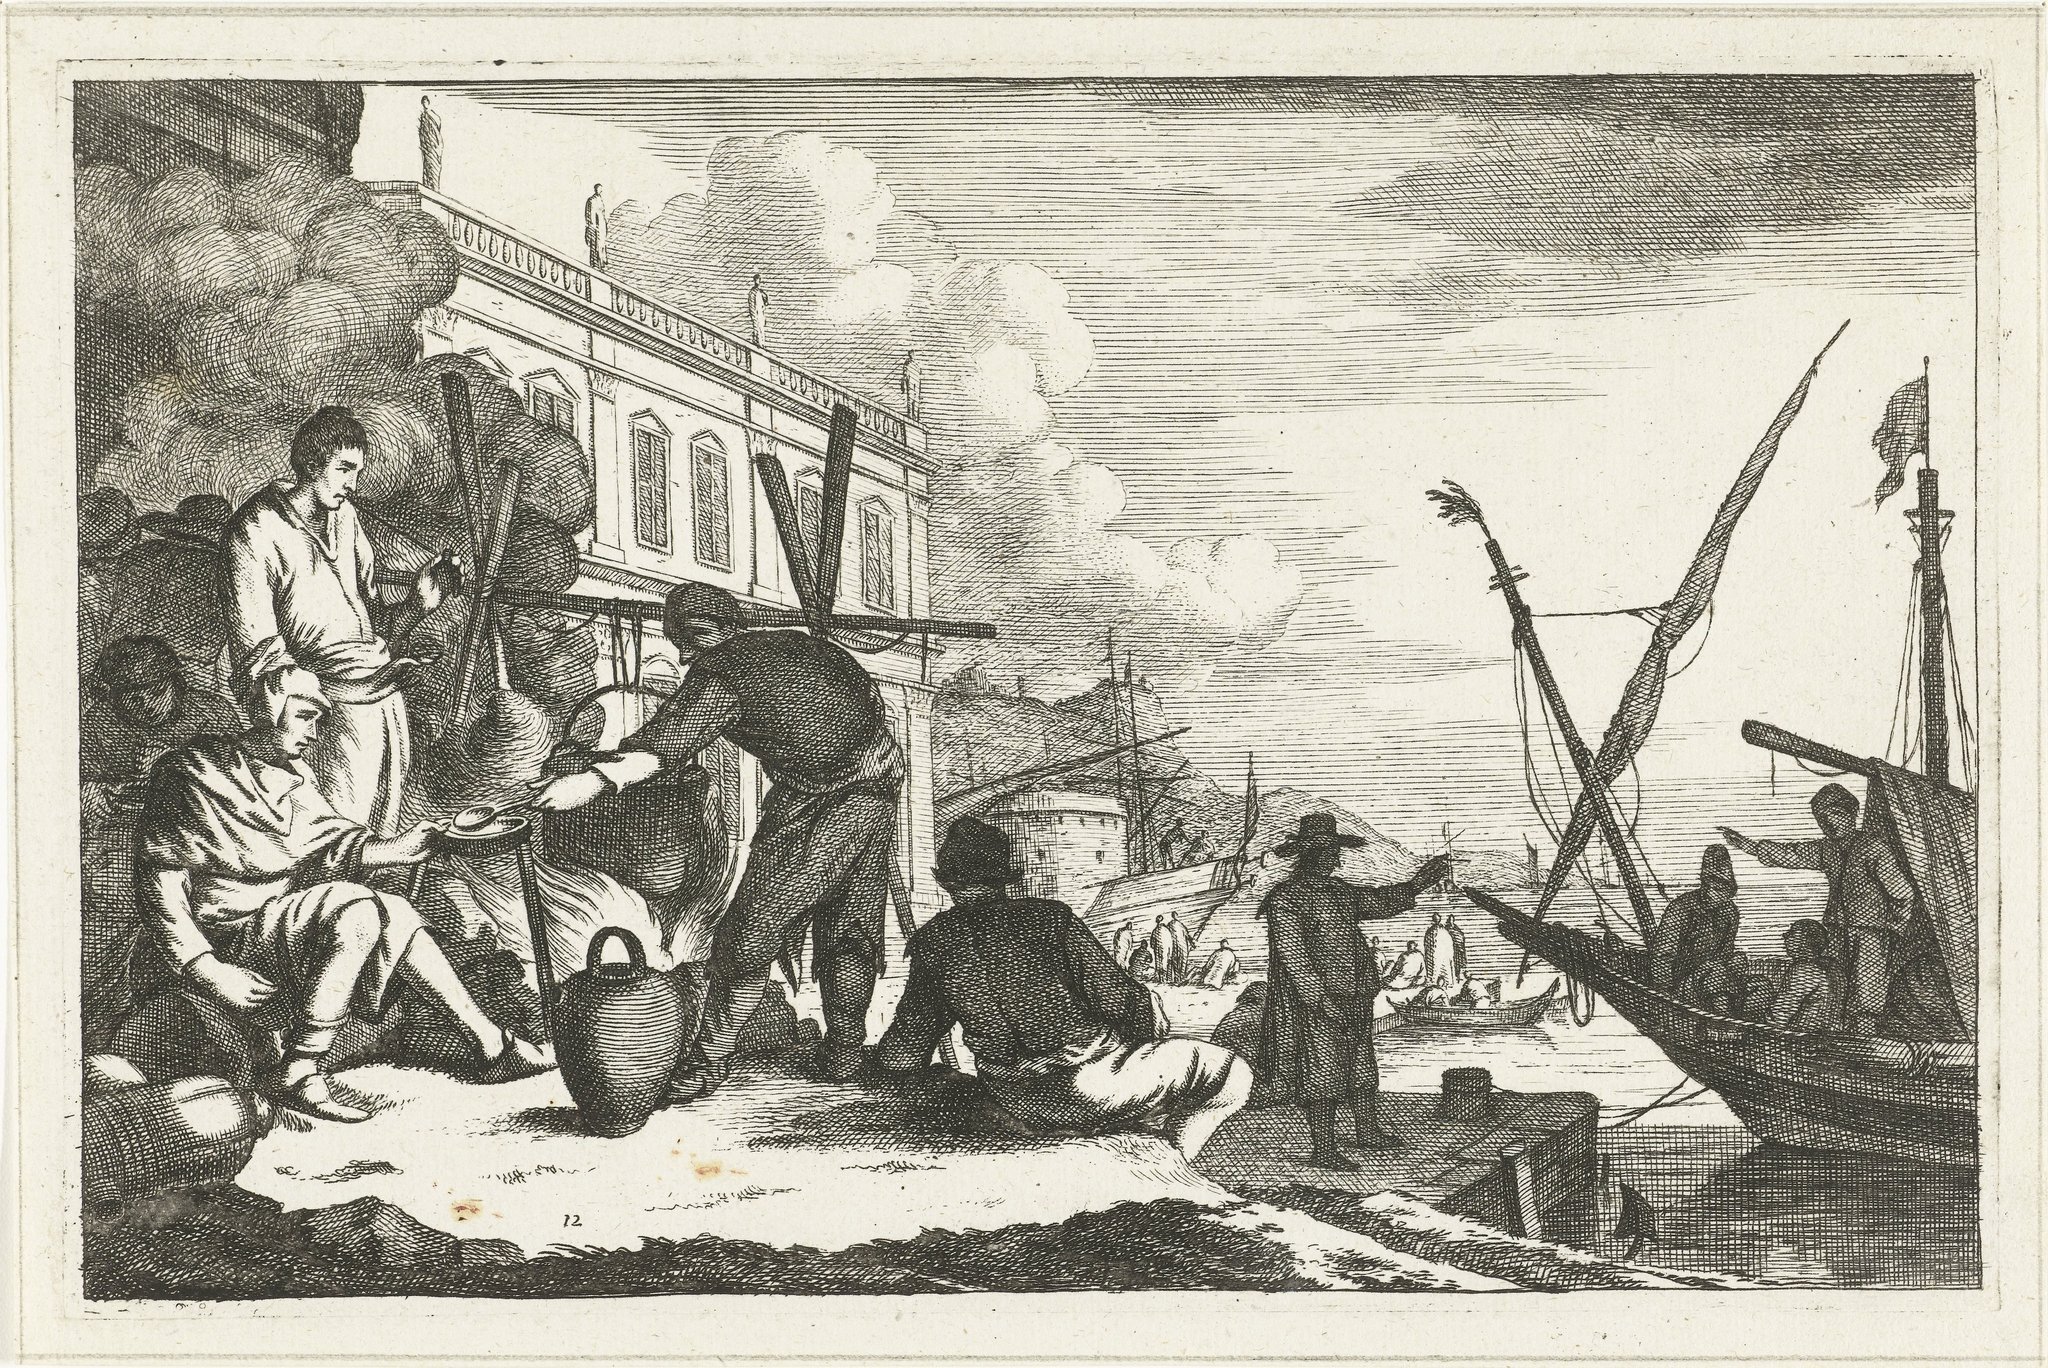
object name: print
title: Italiaanse havens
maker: johannes gronsveld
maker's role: draughtsman, painter, print maker, publisher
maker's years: 1658-1728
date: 1679-1728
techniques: engraving, etching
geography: amsterdam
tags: cooking food - cc - in the open air, harbour (+ four persons or more ~ traffic and transport)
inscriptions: collector's mark: Lugt 2228, collector's mark: ‘b, twee onleesbare letters, l, en een langwerpig figuur’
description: Haven met kooplieden rond een ketel die boven het vuur hangt. Links op de achtergrond een paleis met vier standbeelden op de kroonlijst. En rechts op de kade een man, zwaaiend naar een vertrekkend zeilschip. Twaalfde prent uit een serie van twaalf met Italiaanse havens.